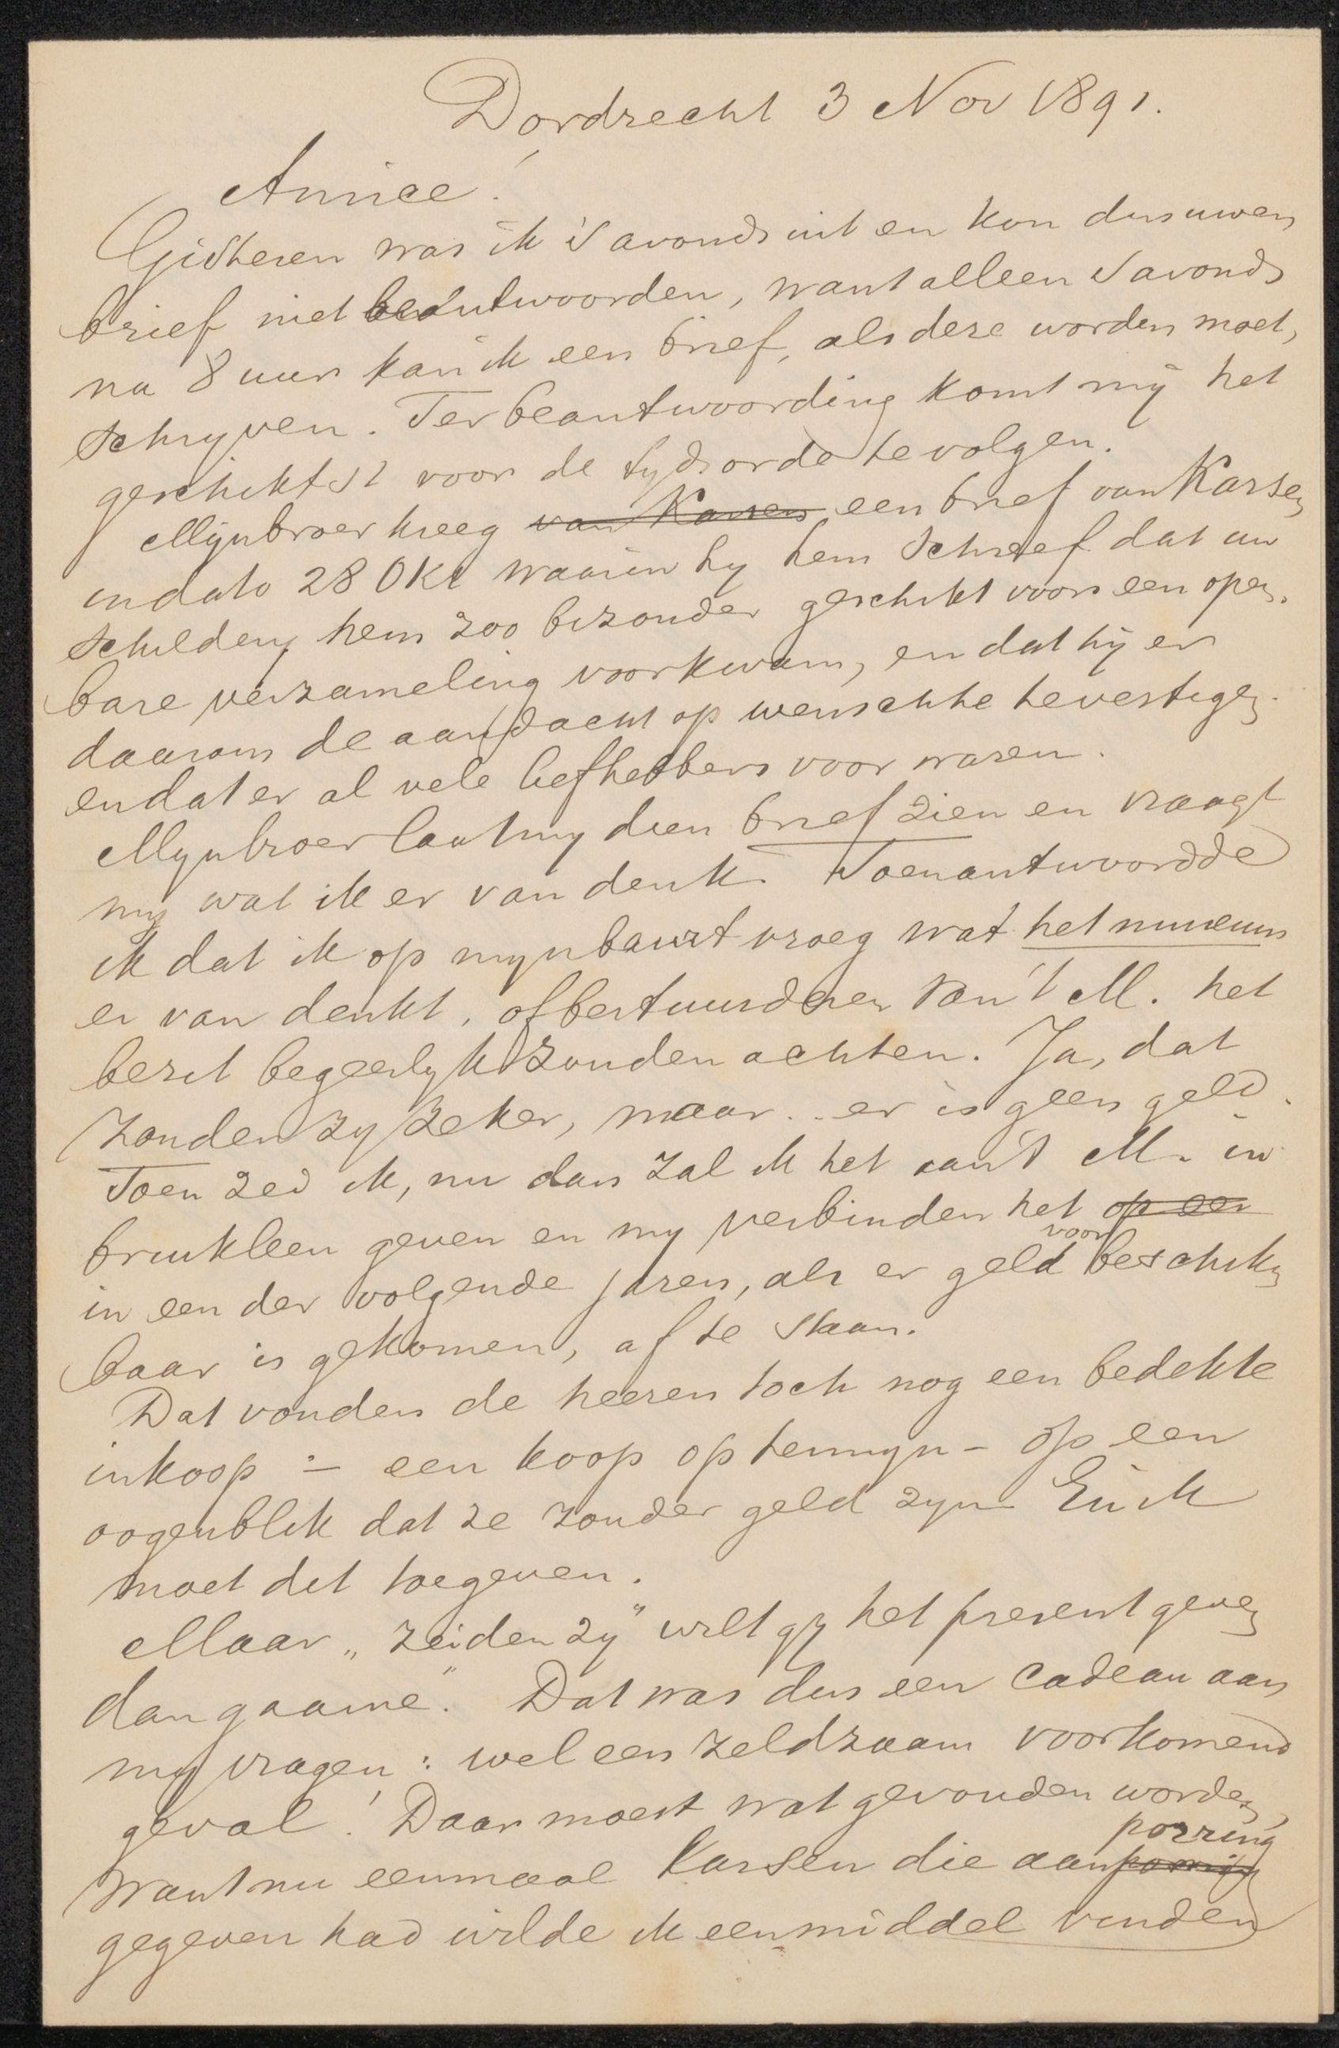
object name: letter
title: Brief aan Jan Veth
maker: martinus cornelis lebret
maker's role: verzamelaar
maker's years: 1833-1894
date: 1891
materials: ink, paper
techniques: pen, writing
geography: dordrecht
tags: amsterdam, designer, jan veth, eduard karsen, utrecht, the hague, antonie cornelis loffelt, dordrecht, painter, draughtsman, painting (including book-illumination, miniature-painting), historical persons (portraits and scenes from the life), money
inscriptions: collector's mark: ‘RPK’